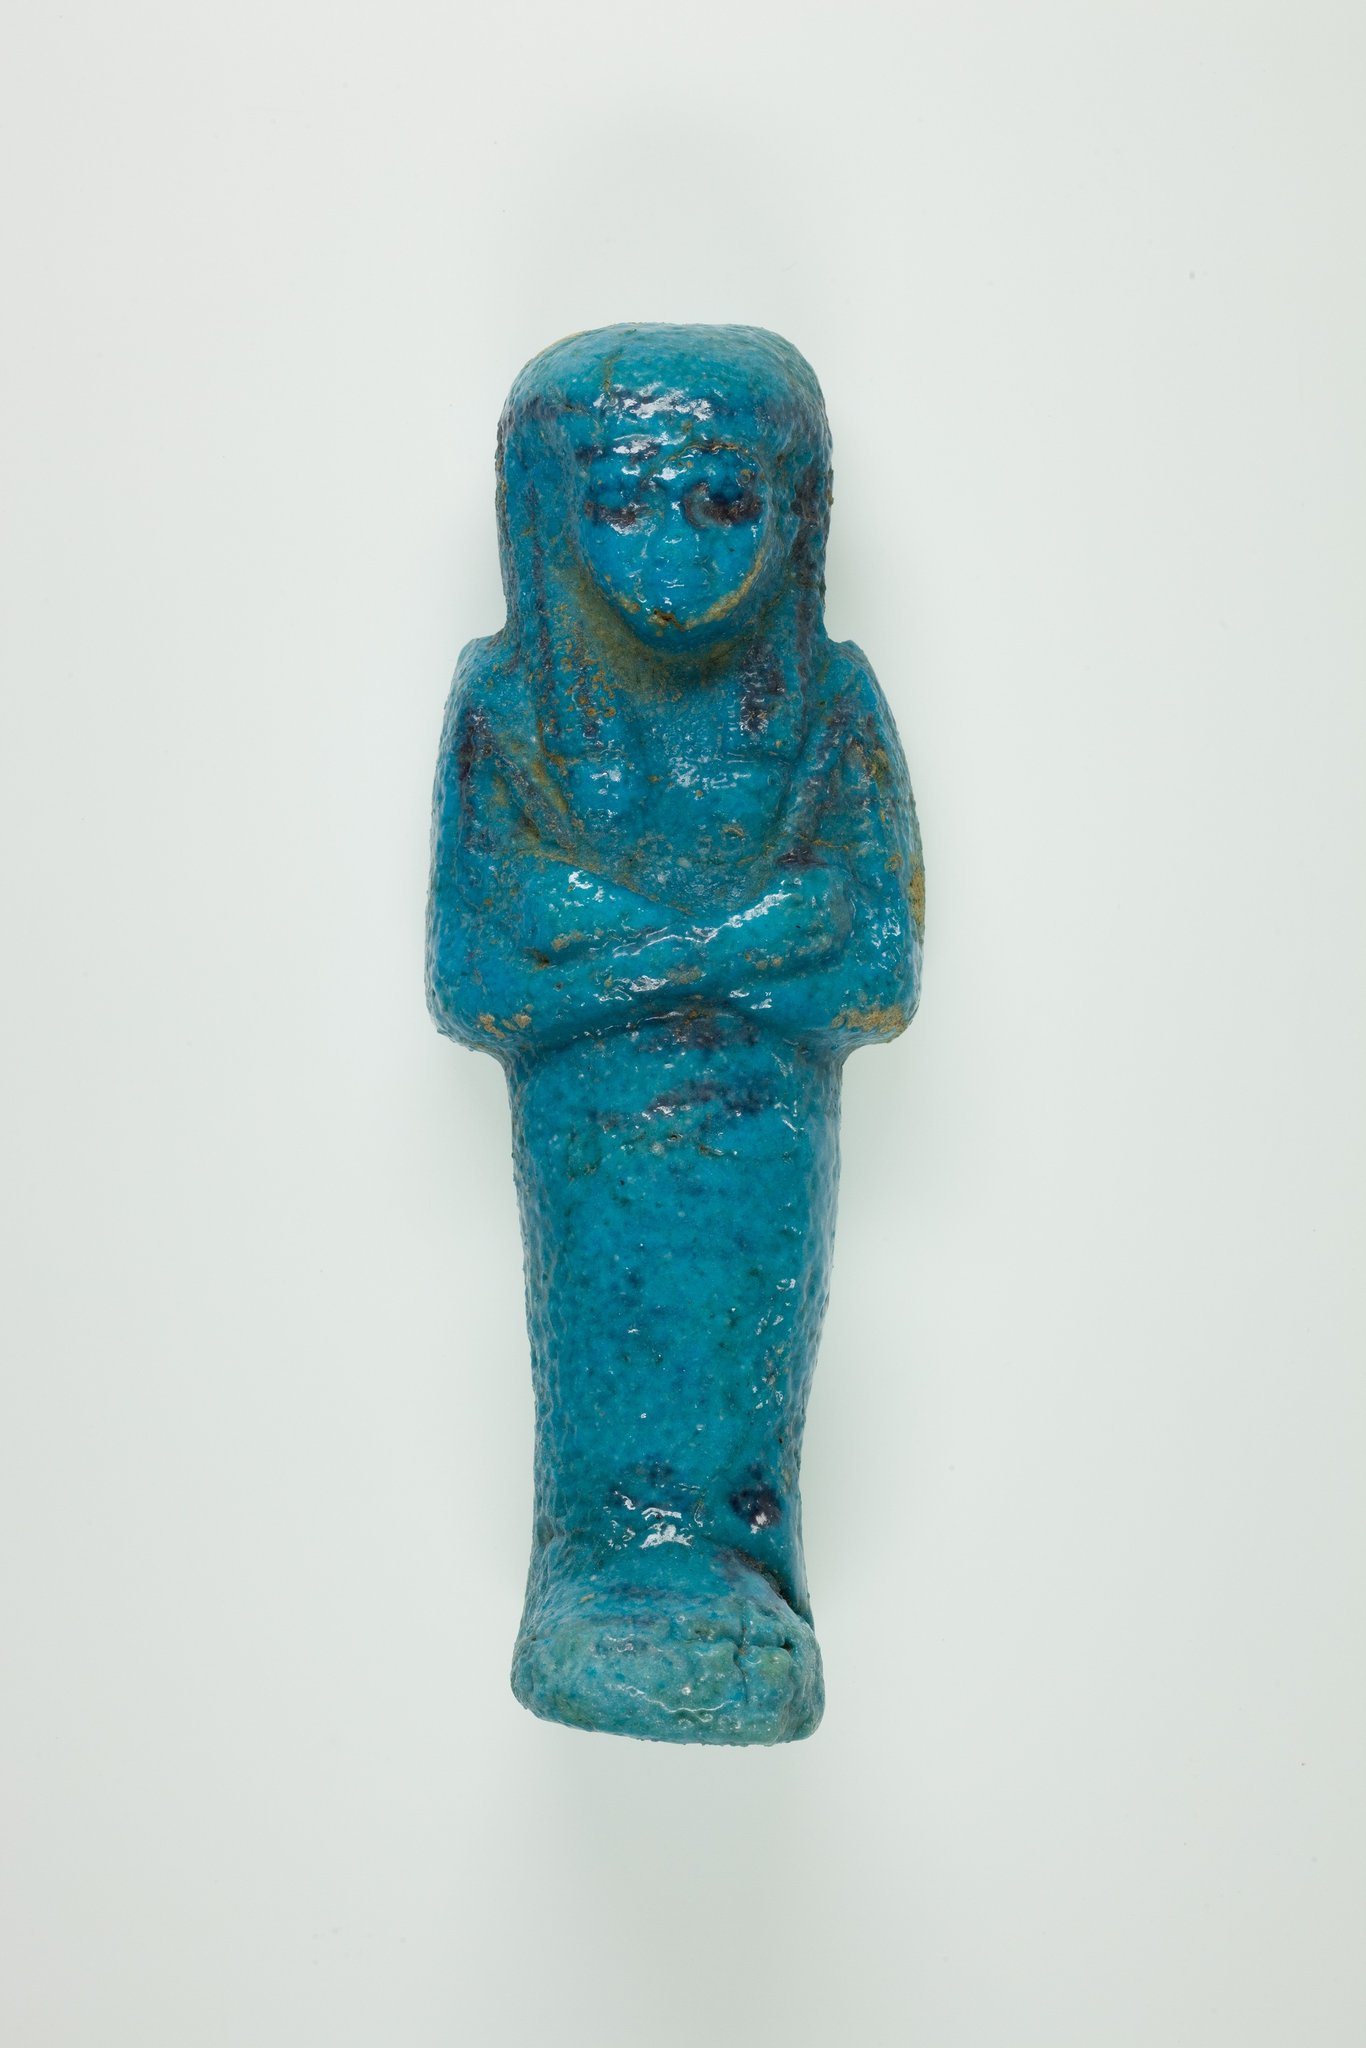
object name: worker shabti, henettawy c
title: Worker Shabti of Henettawy (C), Daughter of Isetemkheb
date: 990-970 BCE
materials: faience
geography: egypt